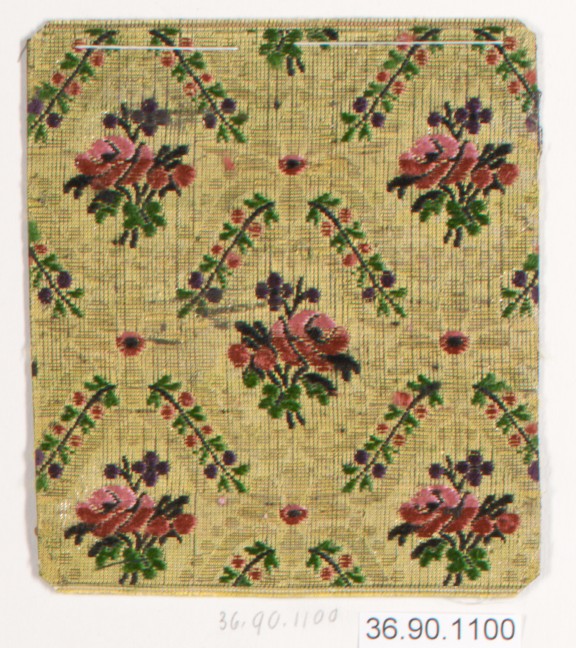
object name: sample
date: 1701-1900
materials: metal thread, silk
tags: flowers